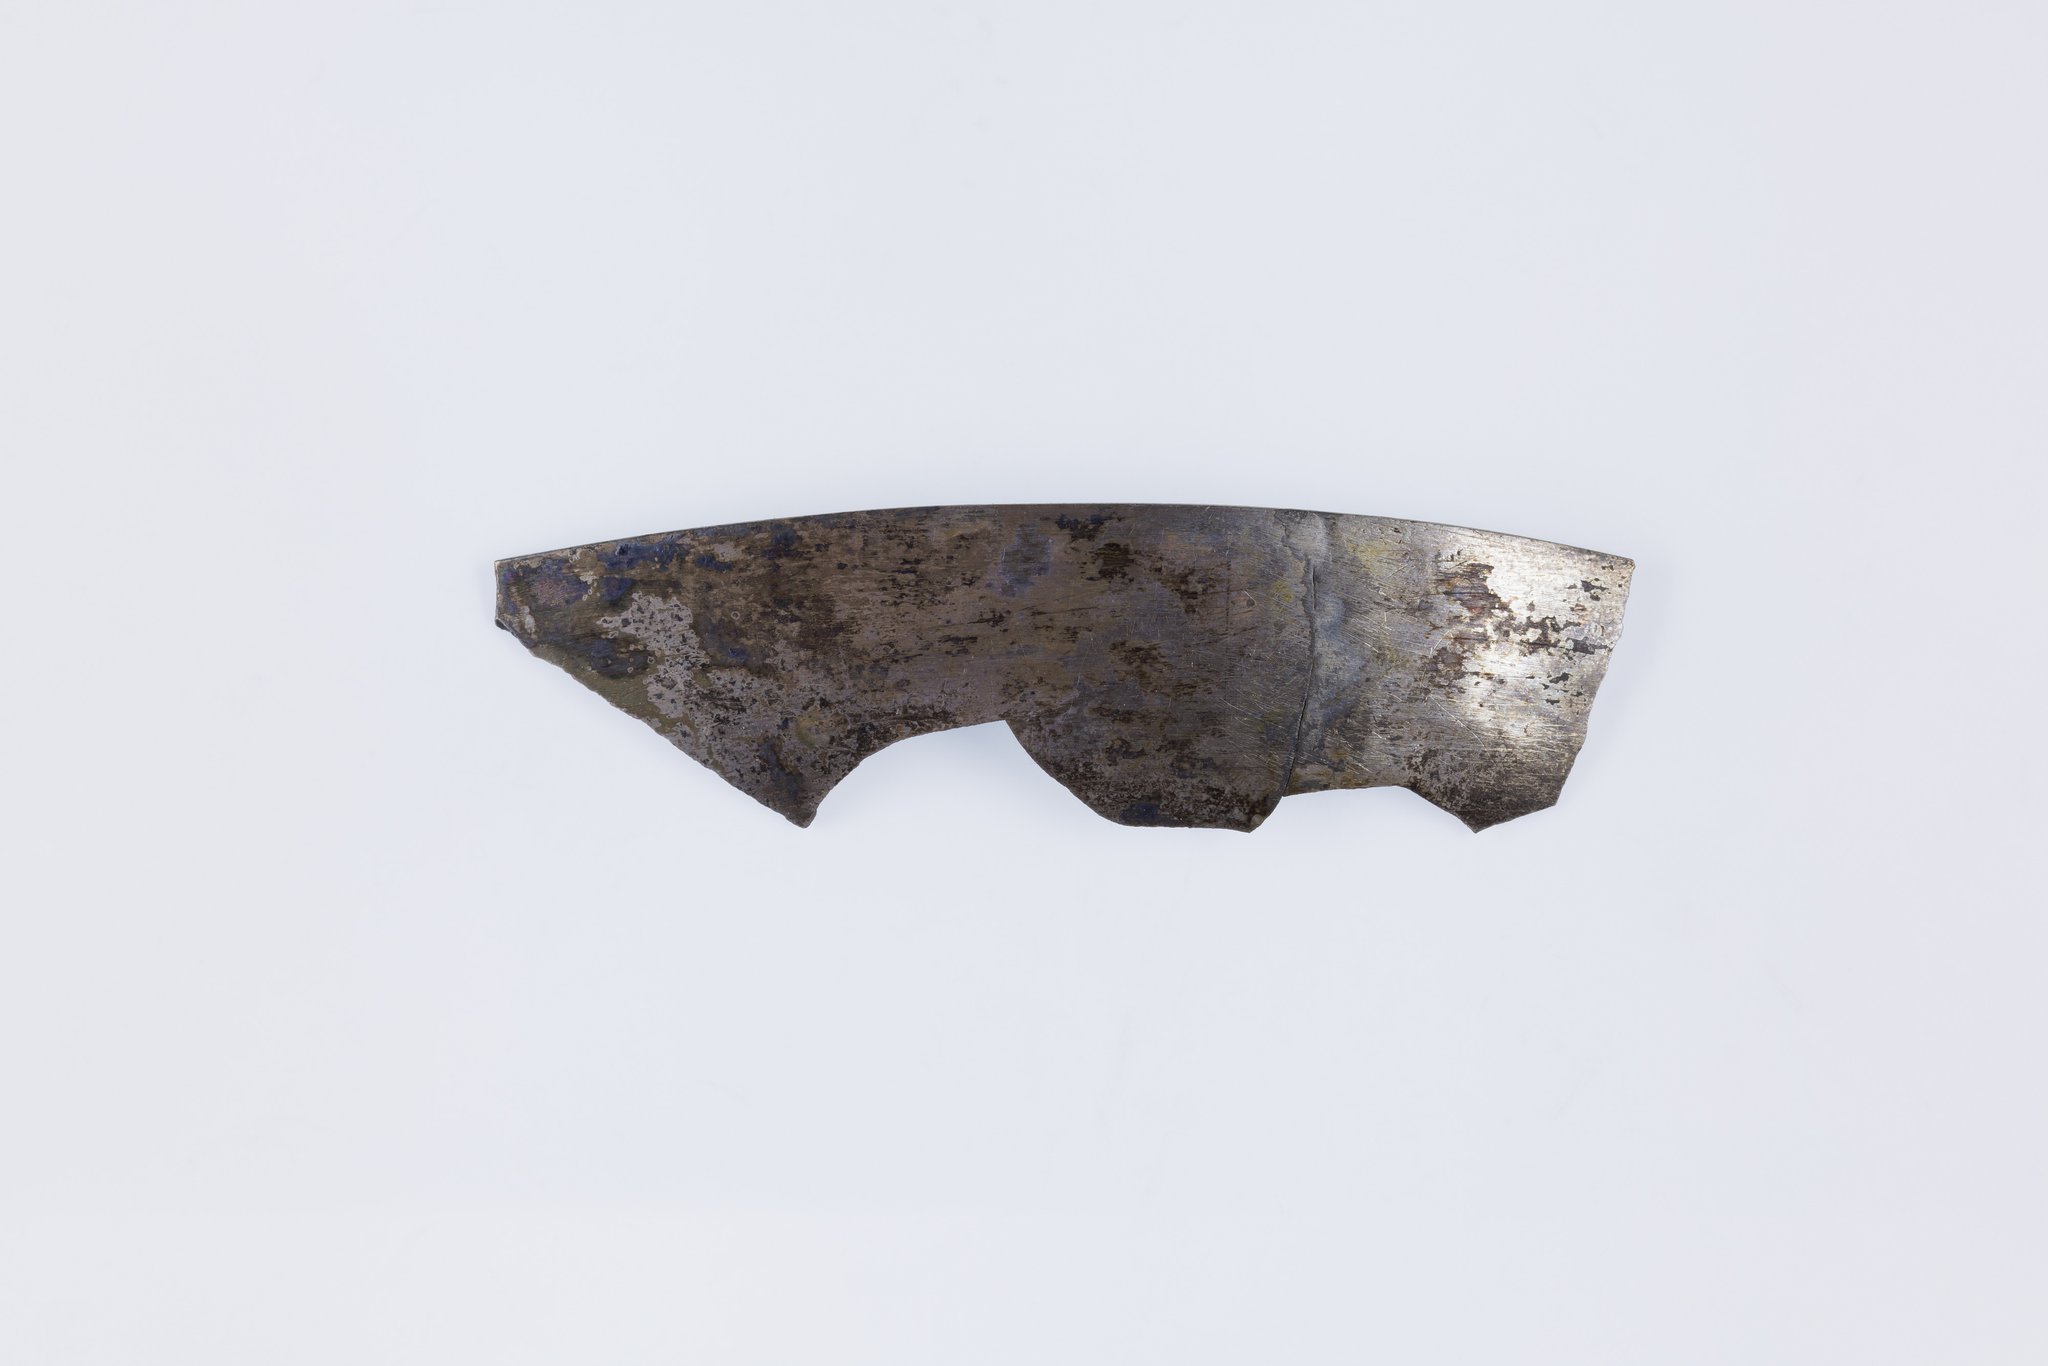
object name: shallow strainer fragment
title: Fragment of shallow strainer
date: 1295-1070 BCE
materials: silver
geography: egypt